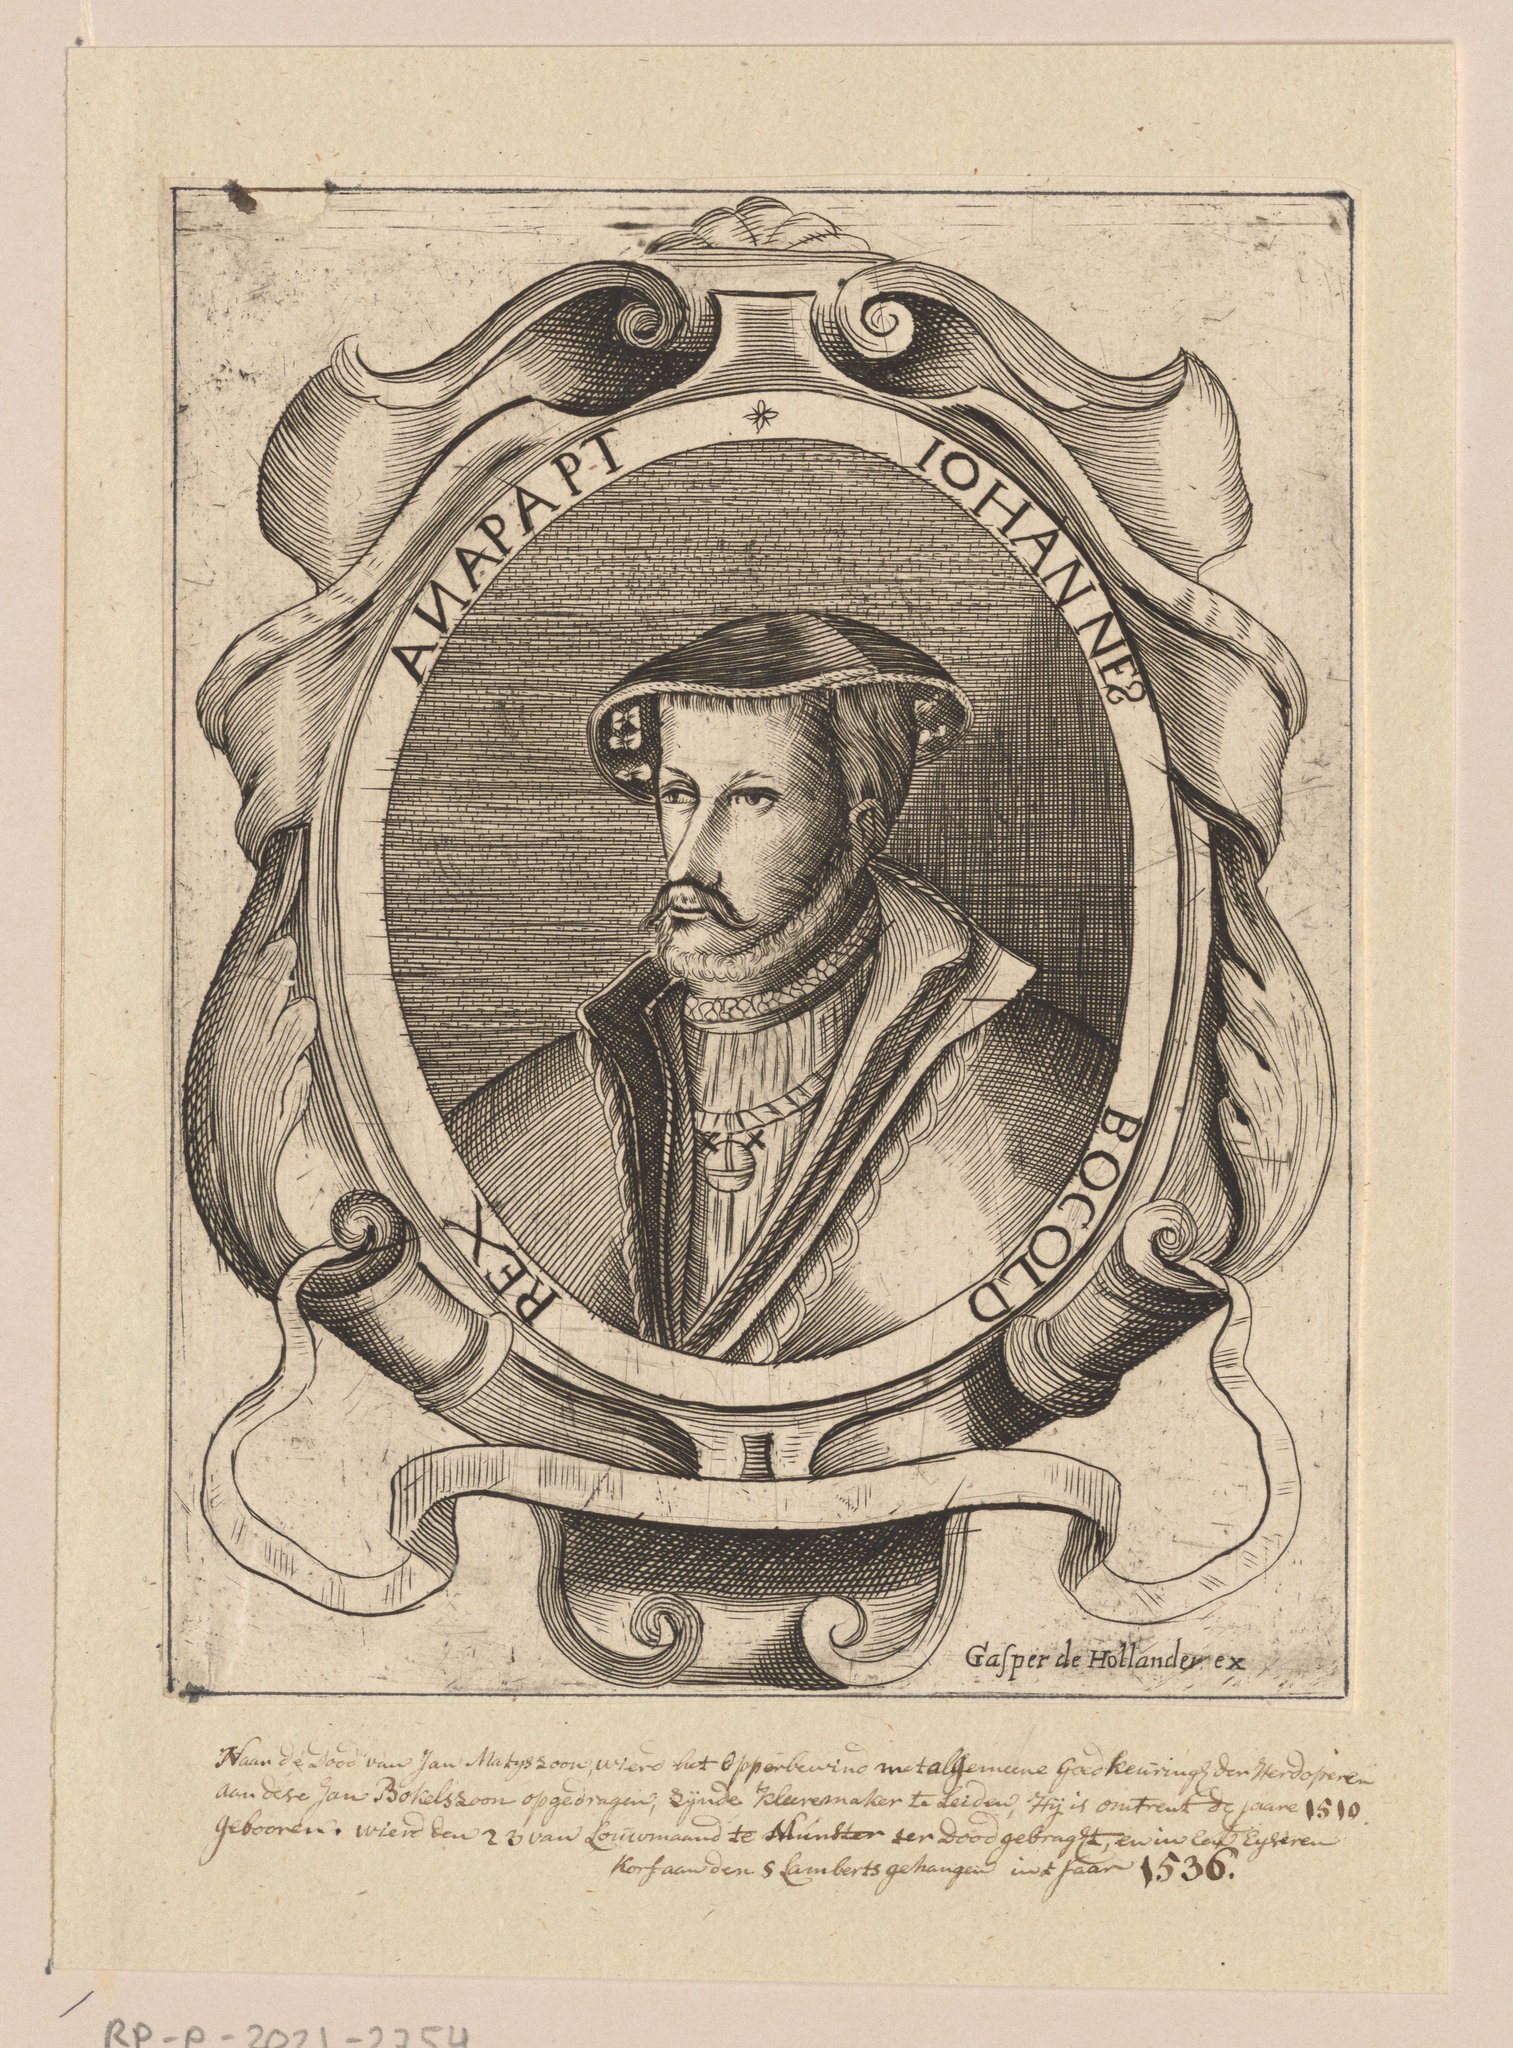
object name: print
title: Portret van Jan van Leiden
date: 1650-1673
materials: paper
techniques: engraving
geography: southern netherlands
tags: leiden, rocaille ornament, ornament ~ medallion, historical persons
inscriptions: inscription: ‘Naar de dood van Jan Matyssoon, wierd het Opperbewind met algemeene goedkeuring der Herdoperen/ aan dese Jan Bokelszoon opgedragen, zijnde Kleeremaker te Leiden, Hij is omtrent de jaare 1510/ gebooren, wierd den 23 van Louwmaand te Munster ter dood gebragt, en in een eyseren/ korf aan den S Lamberts gehangen in t Jaar 1536.’